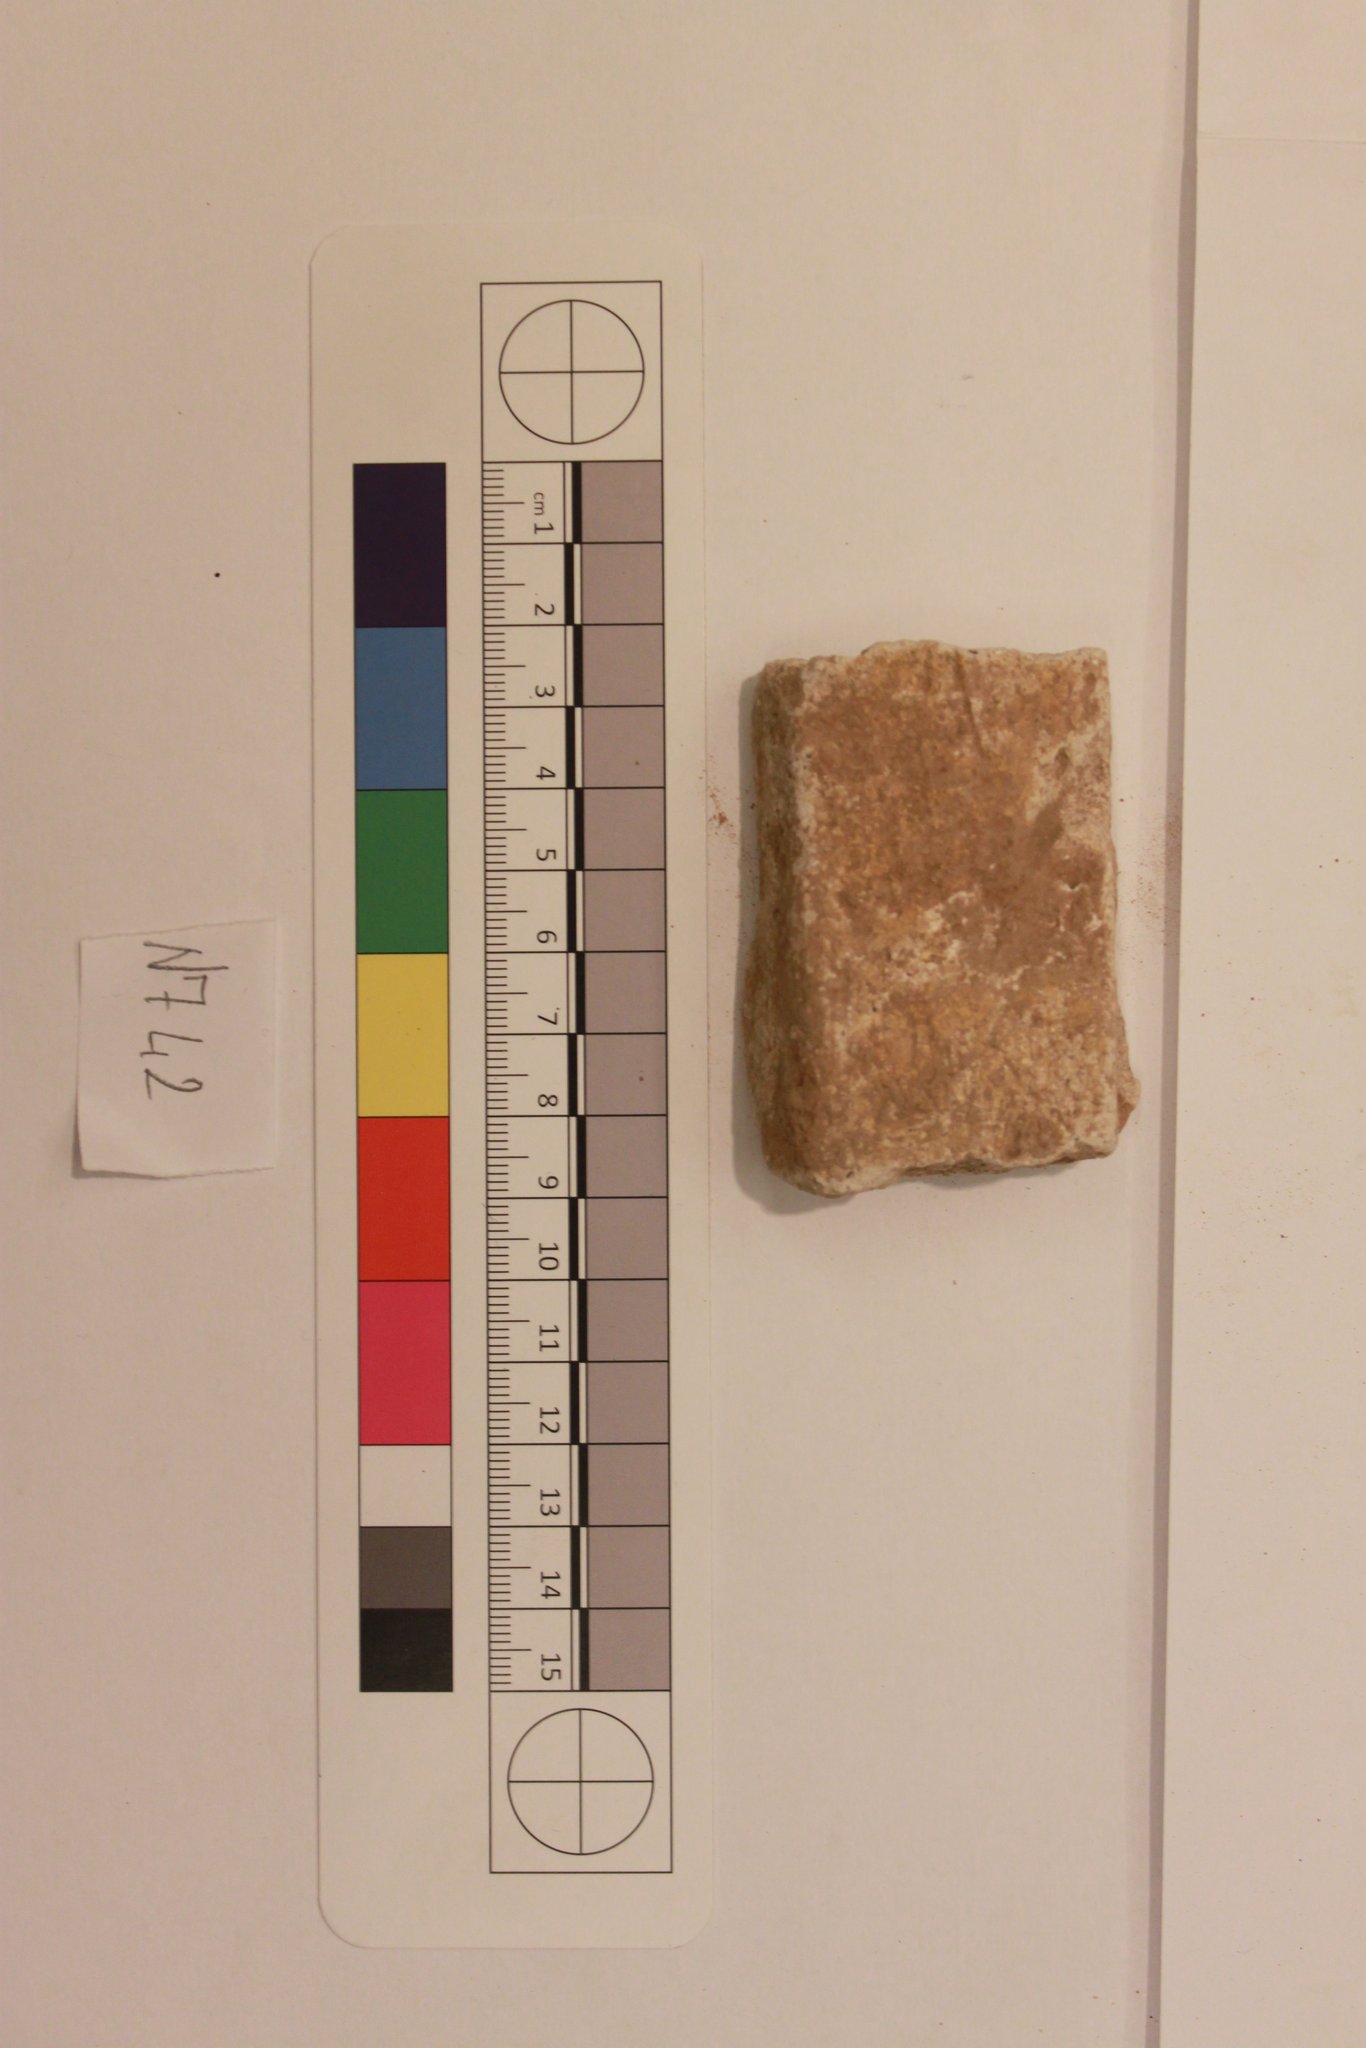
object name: fragment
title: Stucco Fragment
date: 701-1200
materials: plaster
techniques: carving, painting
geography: iran